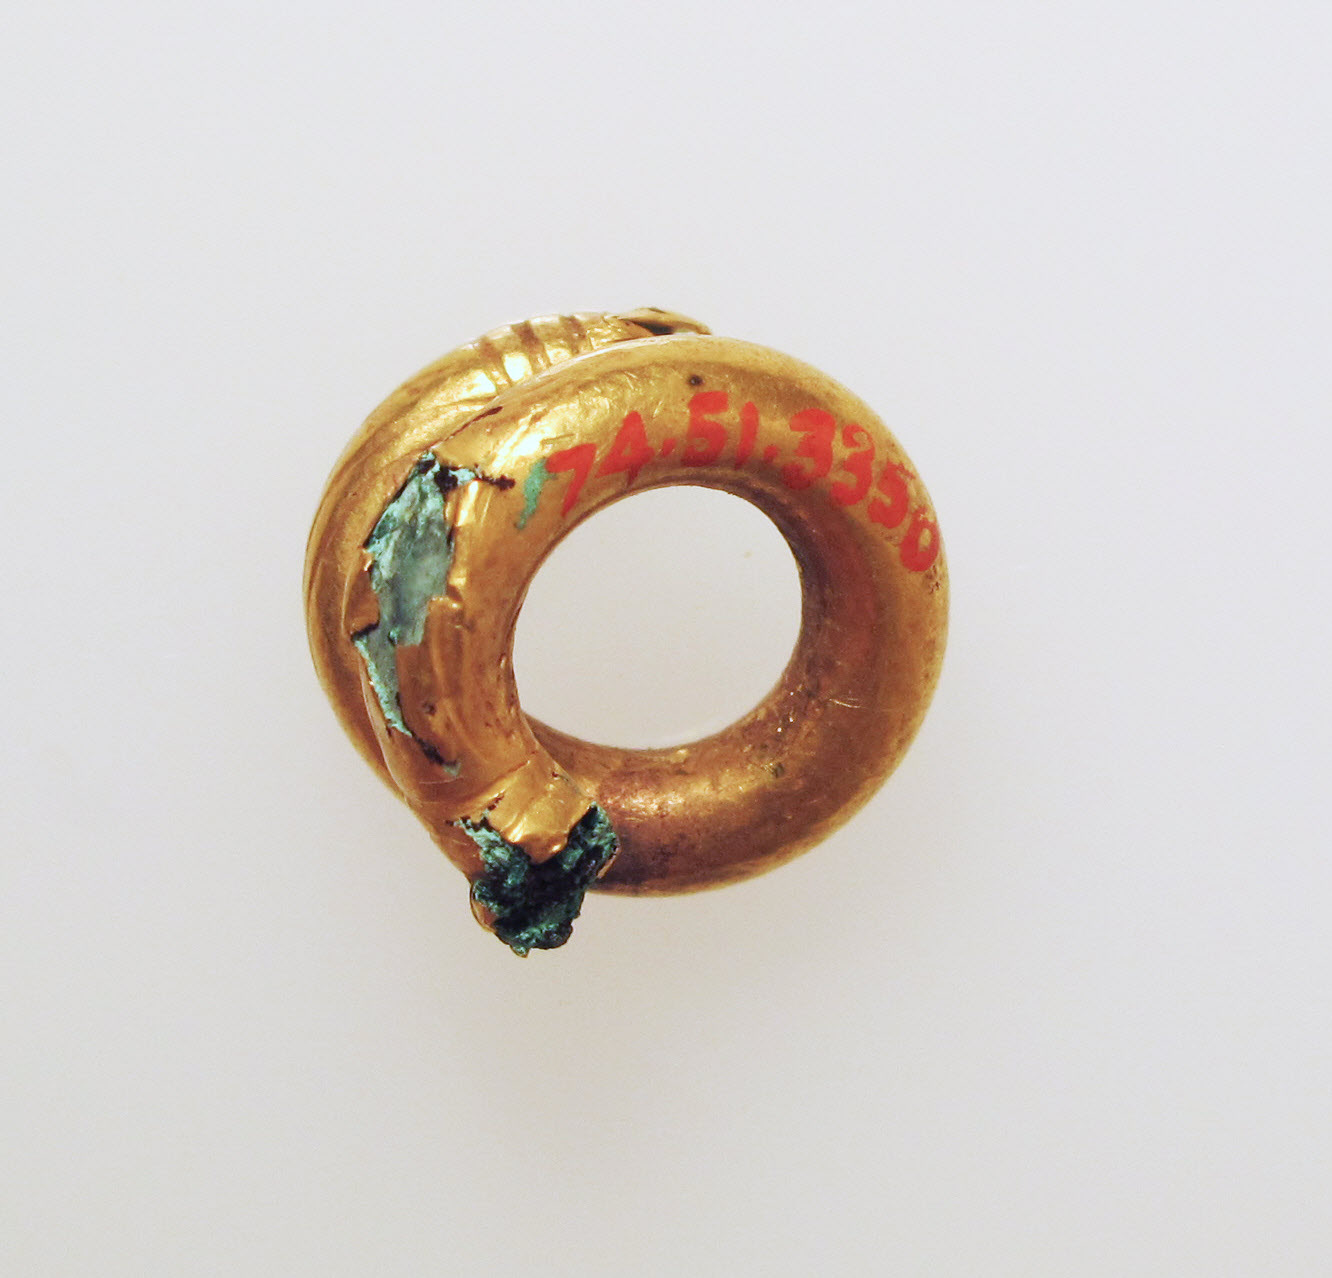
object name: earring or spiral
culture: cypriot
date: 500-401 BCE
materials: bronze, gold